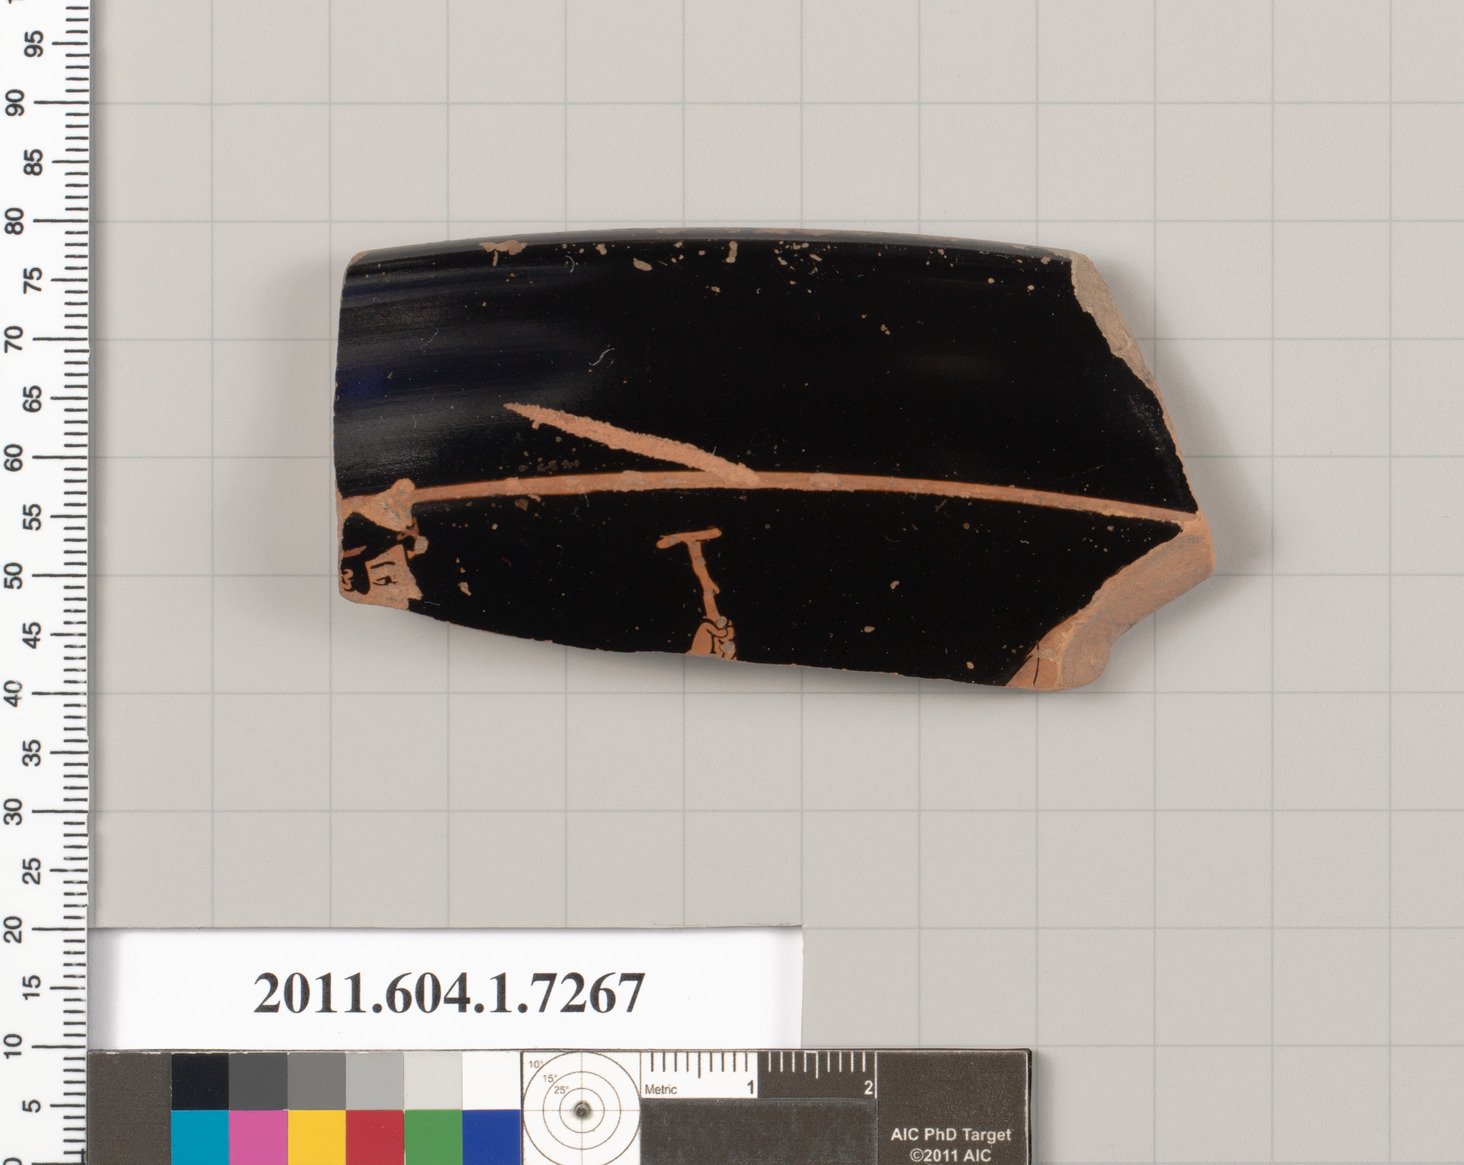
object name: kylix fragment, lipped inside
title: Terracotta rim fragment of a kylix (drinking cup)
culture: greek, attic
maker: makron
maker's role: artist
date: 500-480 BCE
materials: terracotta